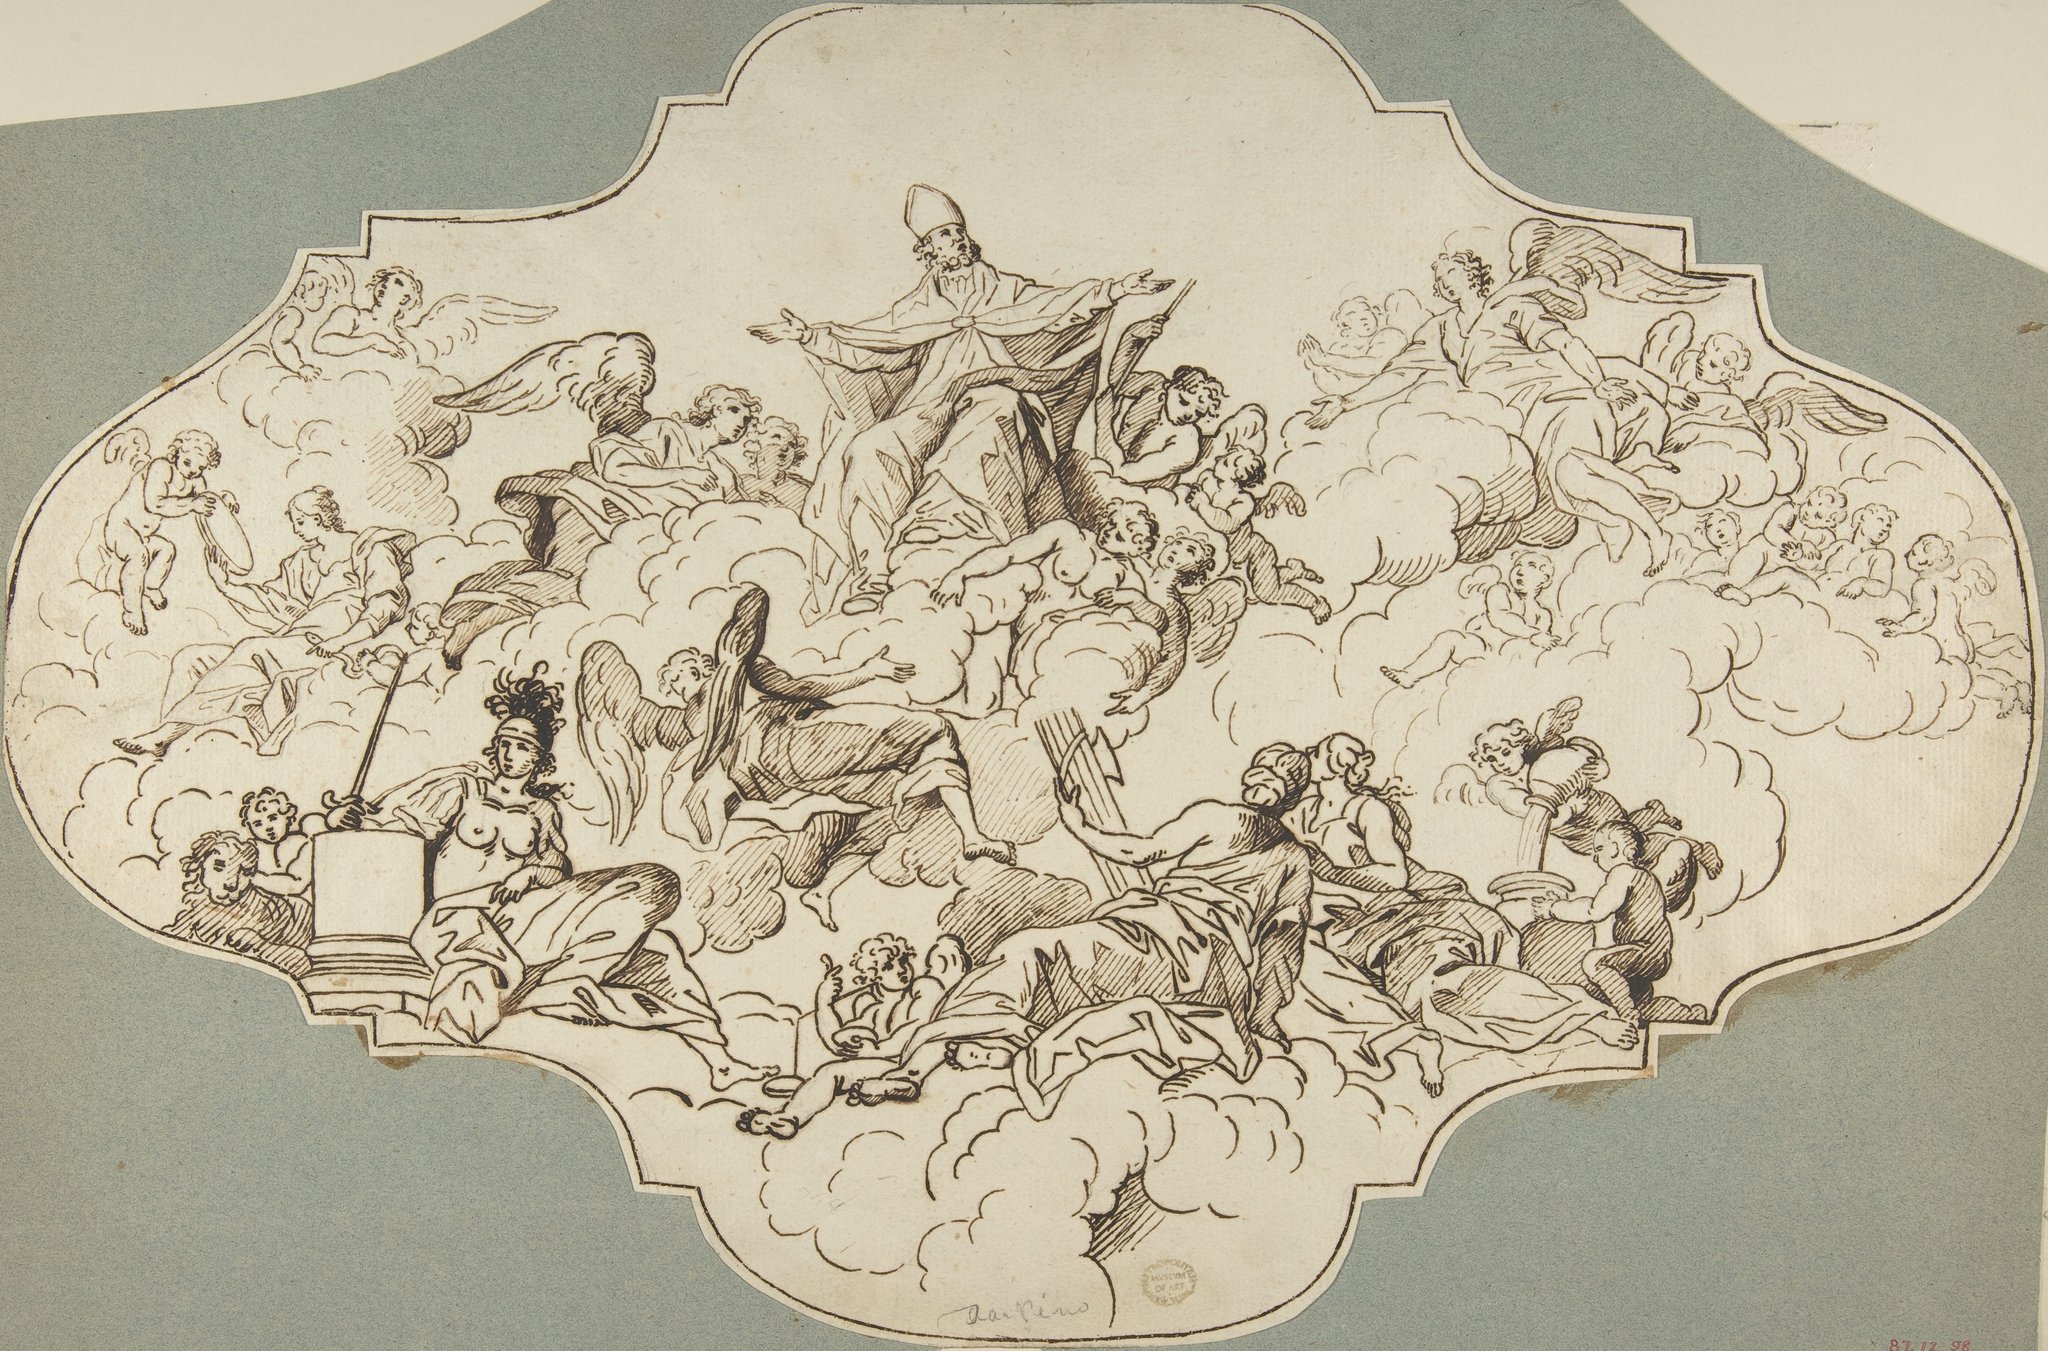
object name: drawing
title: Study for a Ceiling Panel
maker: anonymous, italian, roman-bolognese, 18th century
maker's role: artist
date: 1701-1800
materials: chalk, ink, paper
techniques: pen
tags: men,women,putti,angels